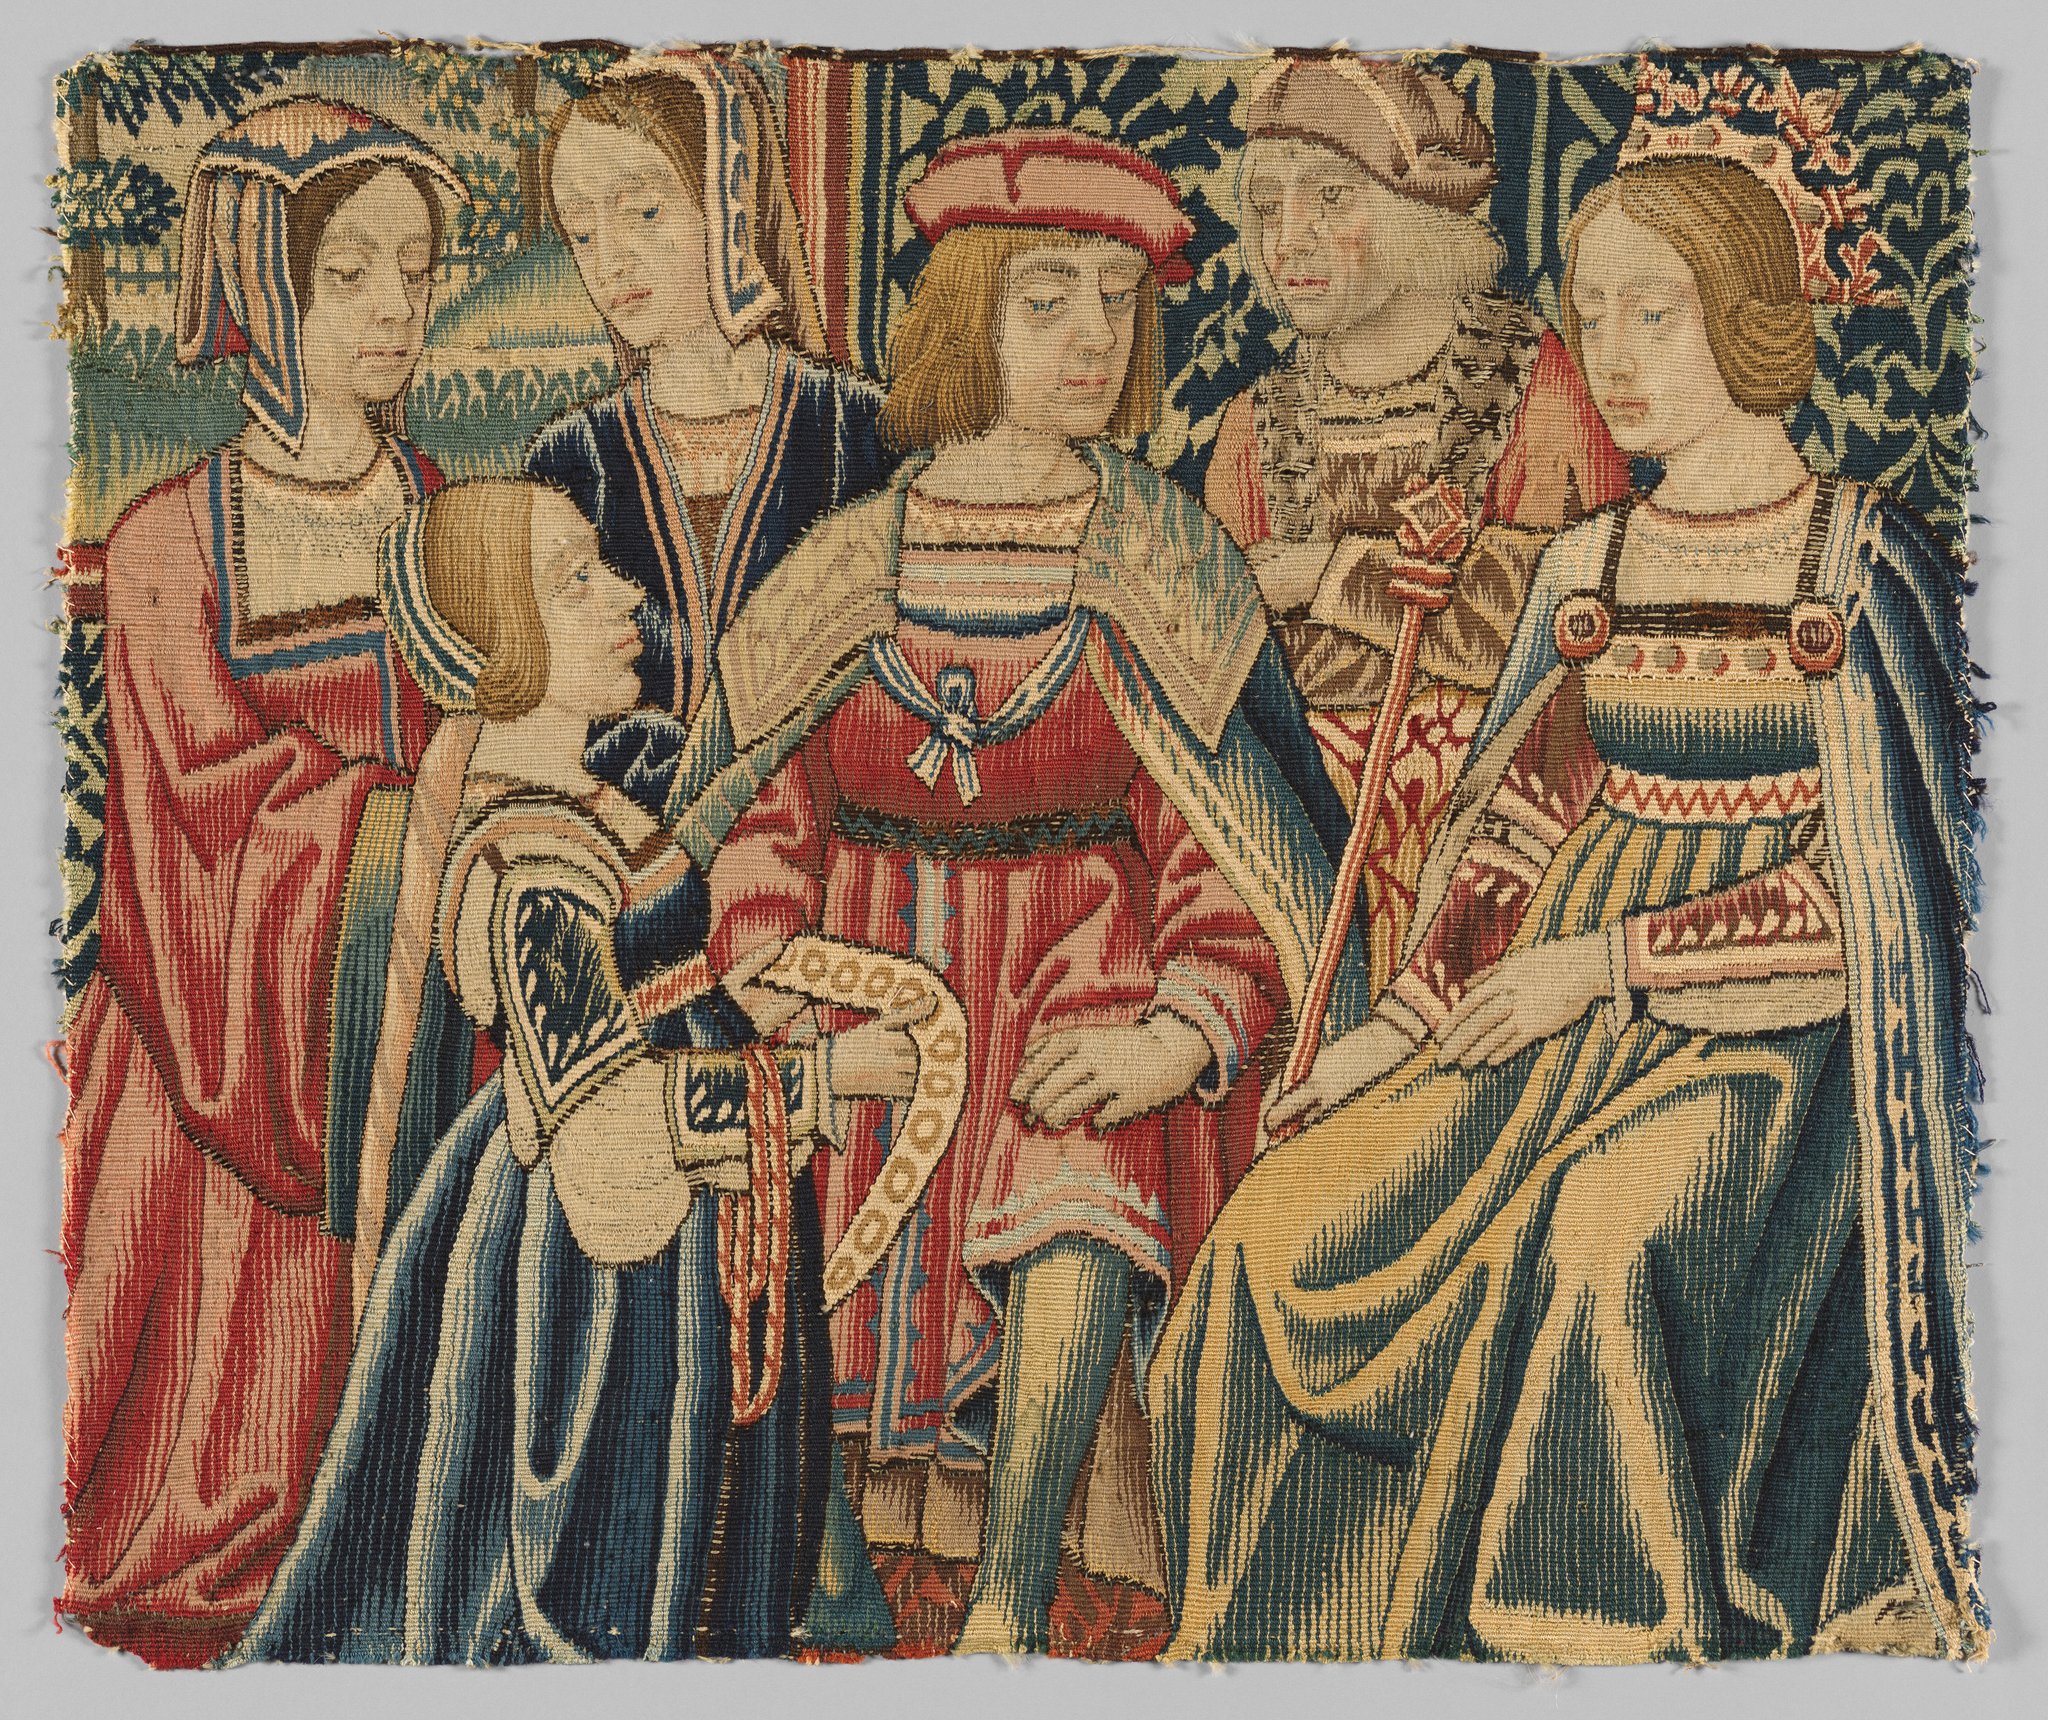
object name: tapestry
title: Courtly Scenes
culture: south netherlandish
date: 1510-1525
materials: silk, wool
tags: men,women